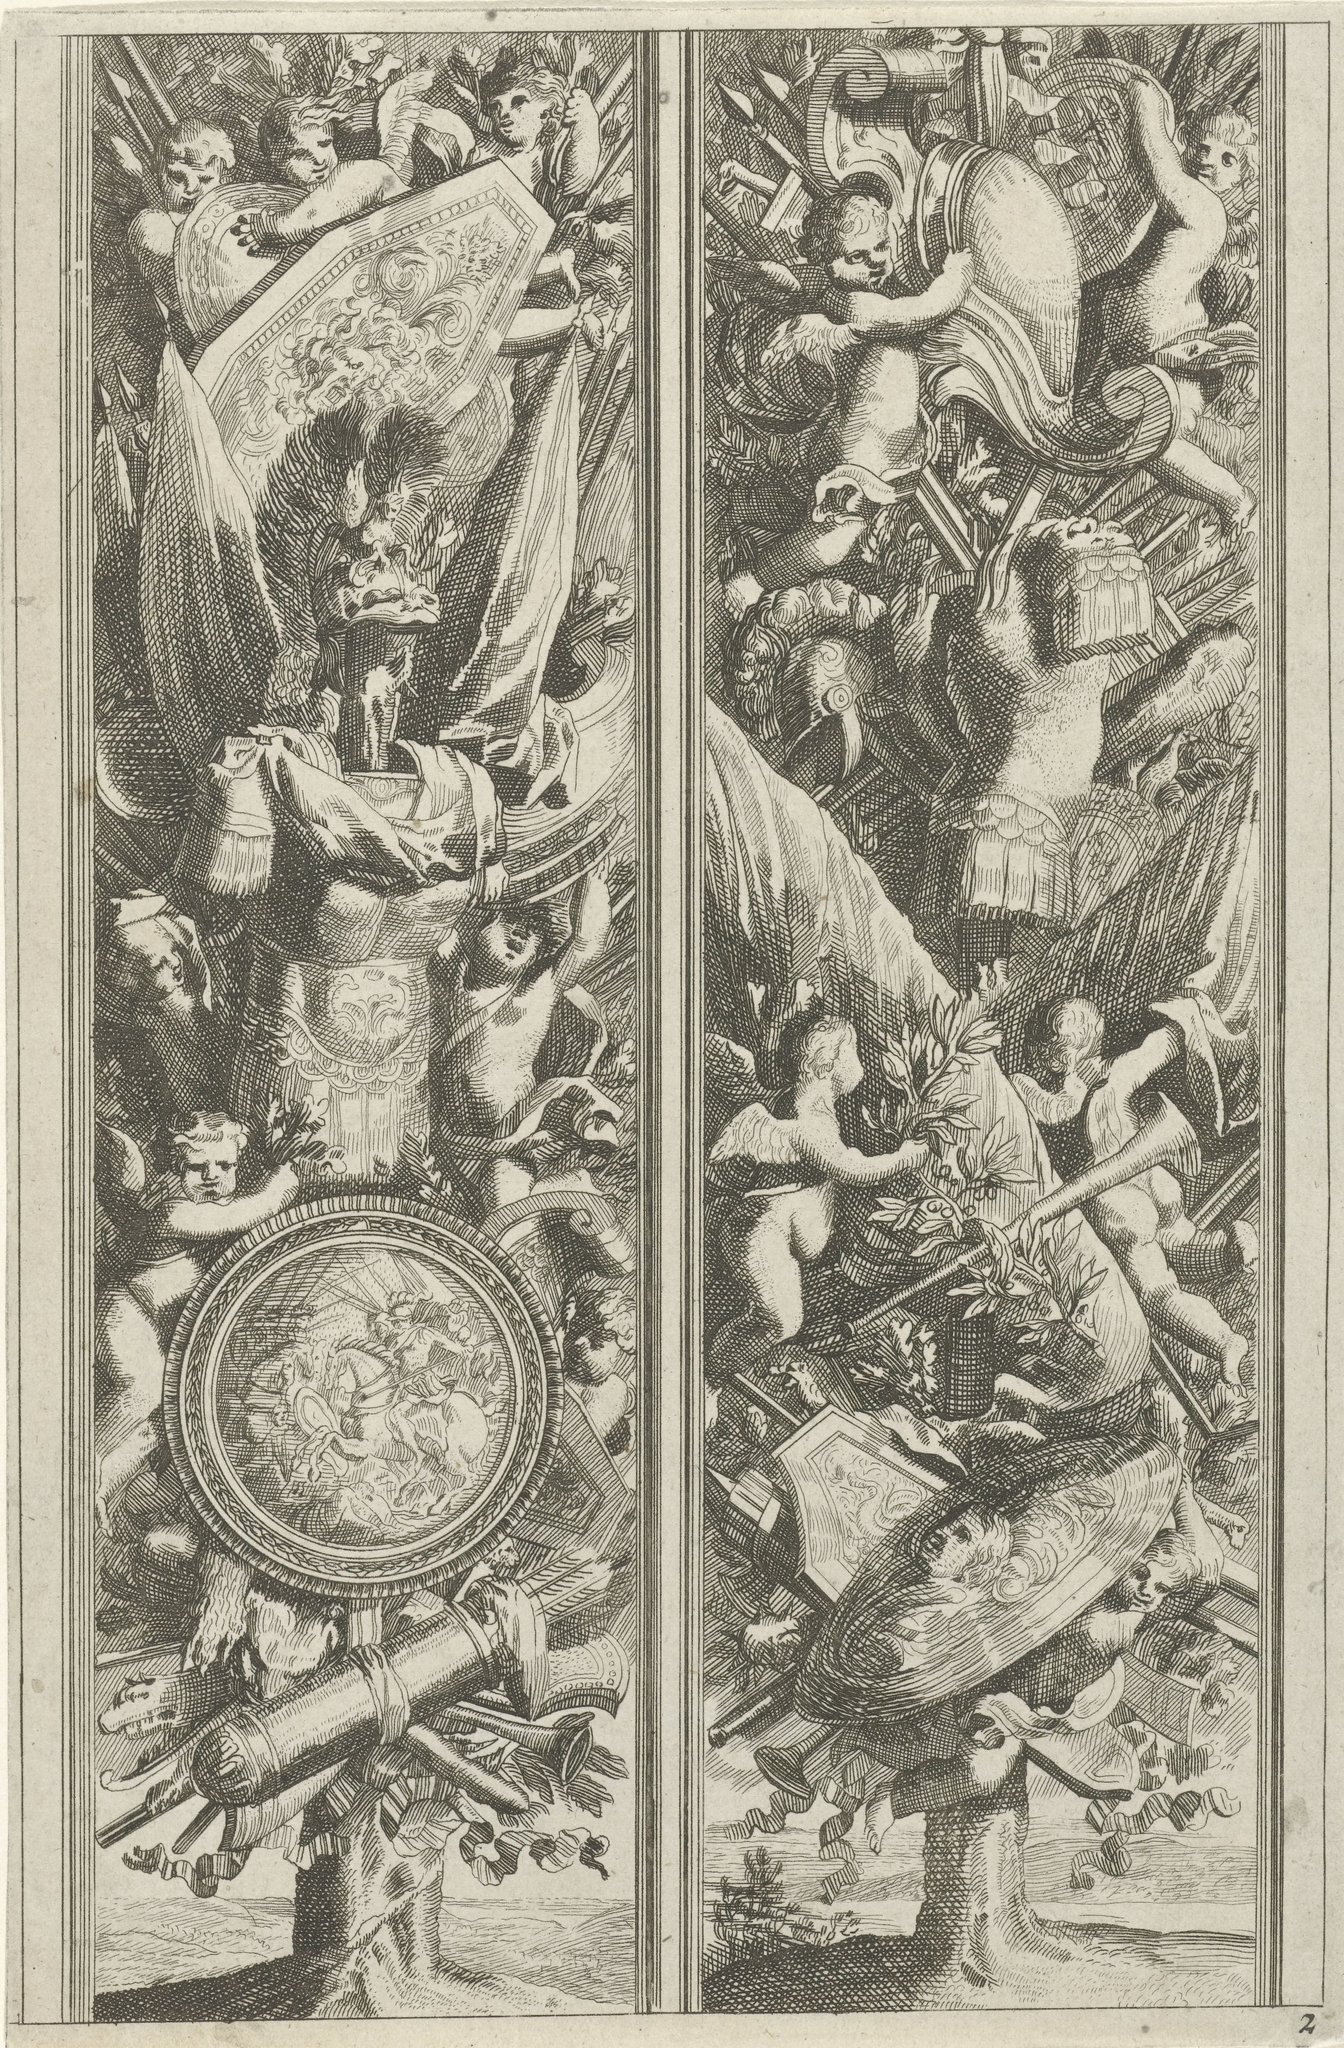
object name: ornament print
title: Trophées D'Armes à la Romaine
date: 1657-1670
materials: paper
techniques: etching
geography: paris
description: Rond schild met strijdende cavalerie in het midden van de trofee.